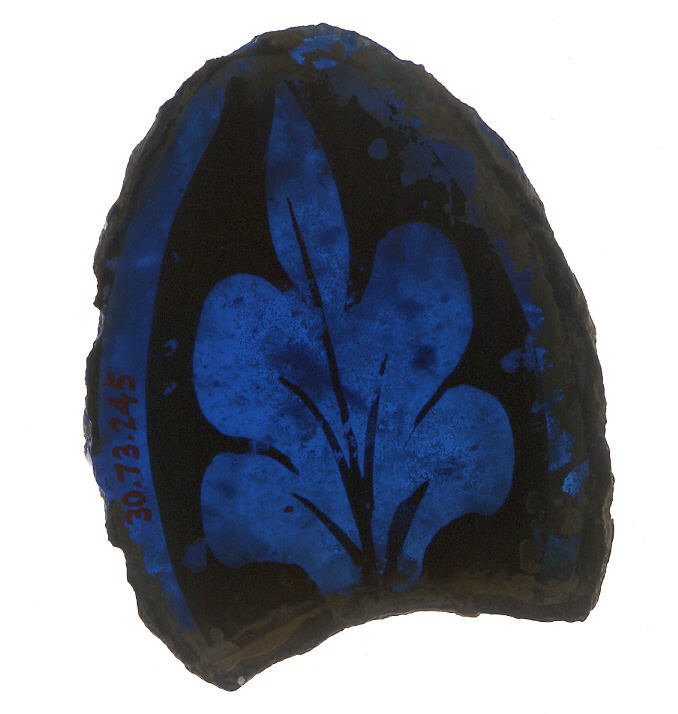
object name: fragment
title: Glass Fragment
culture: european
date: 1201-1400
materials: glass, metal